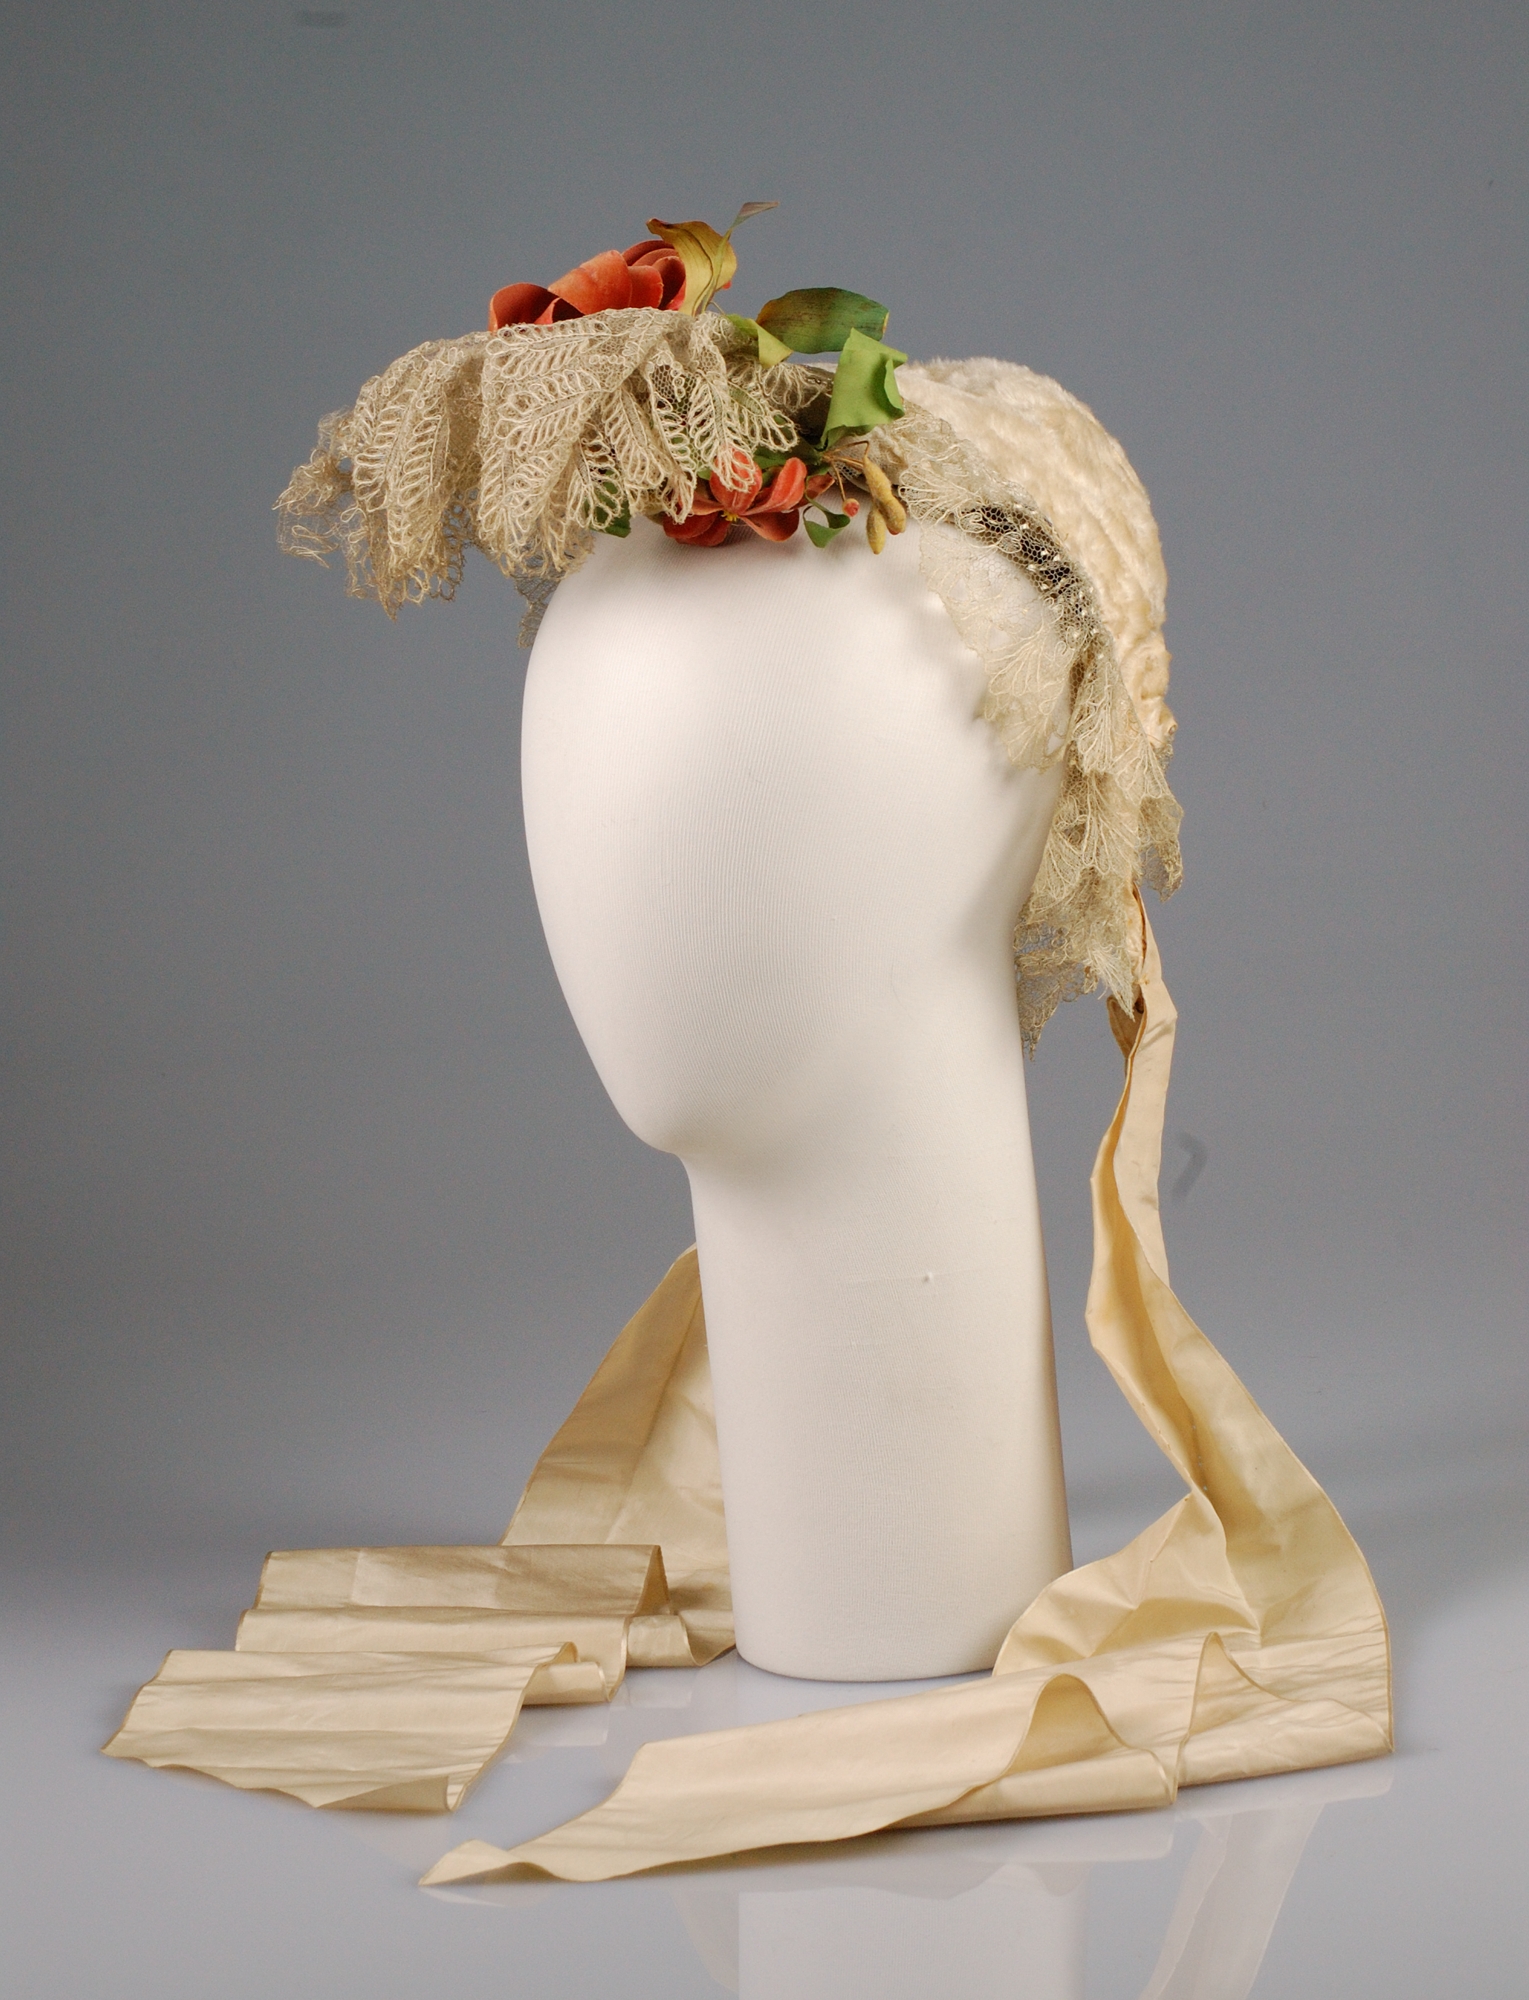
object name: bonnet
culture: american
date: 1863-1868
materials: linen, silk